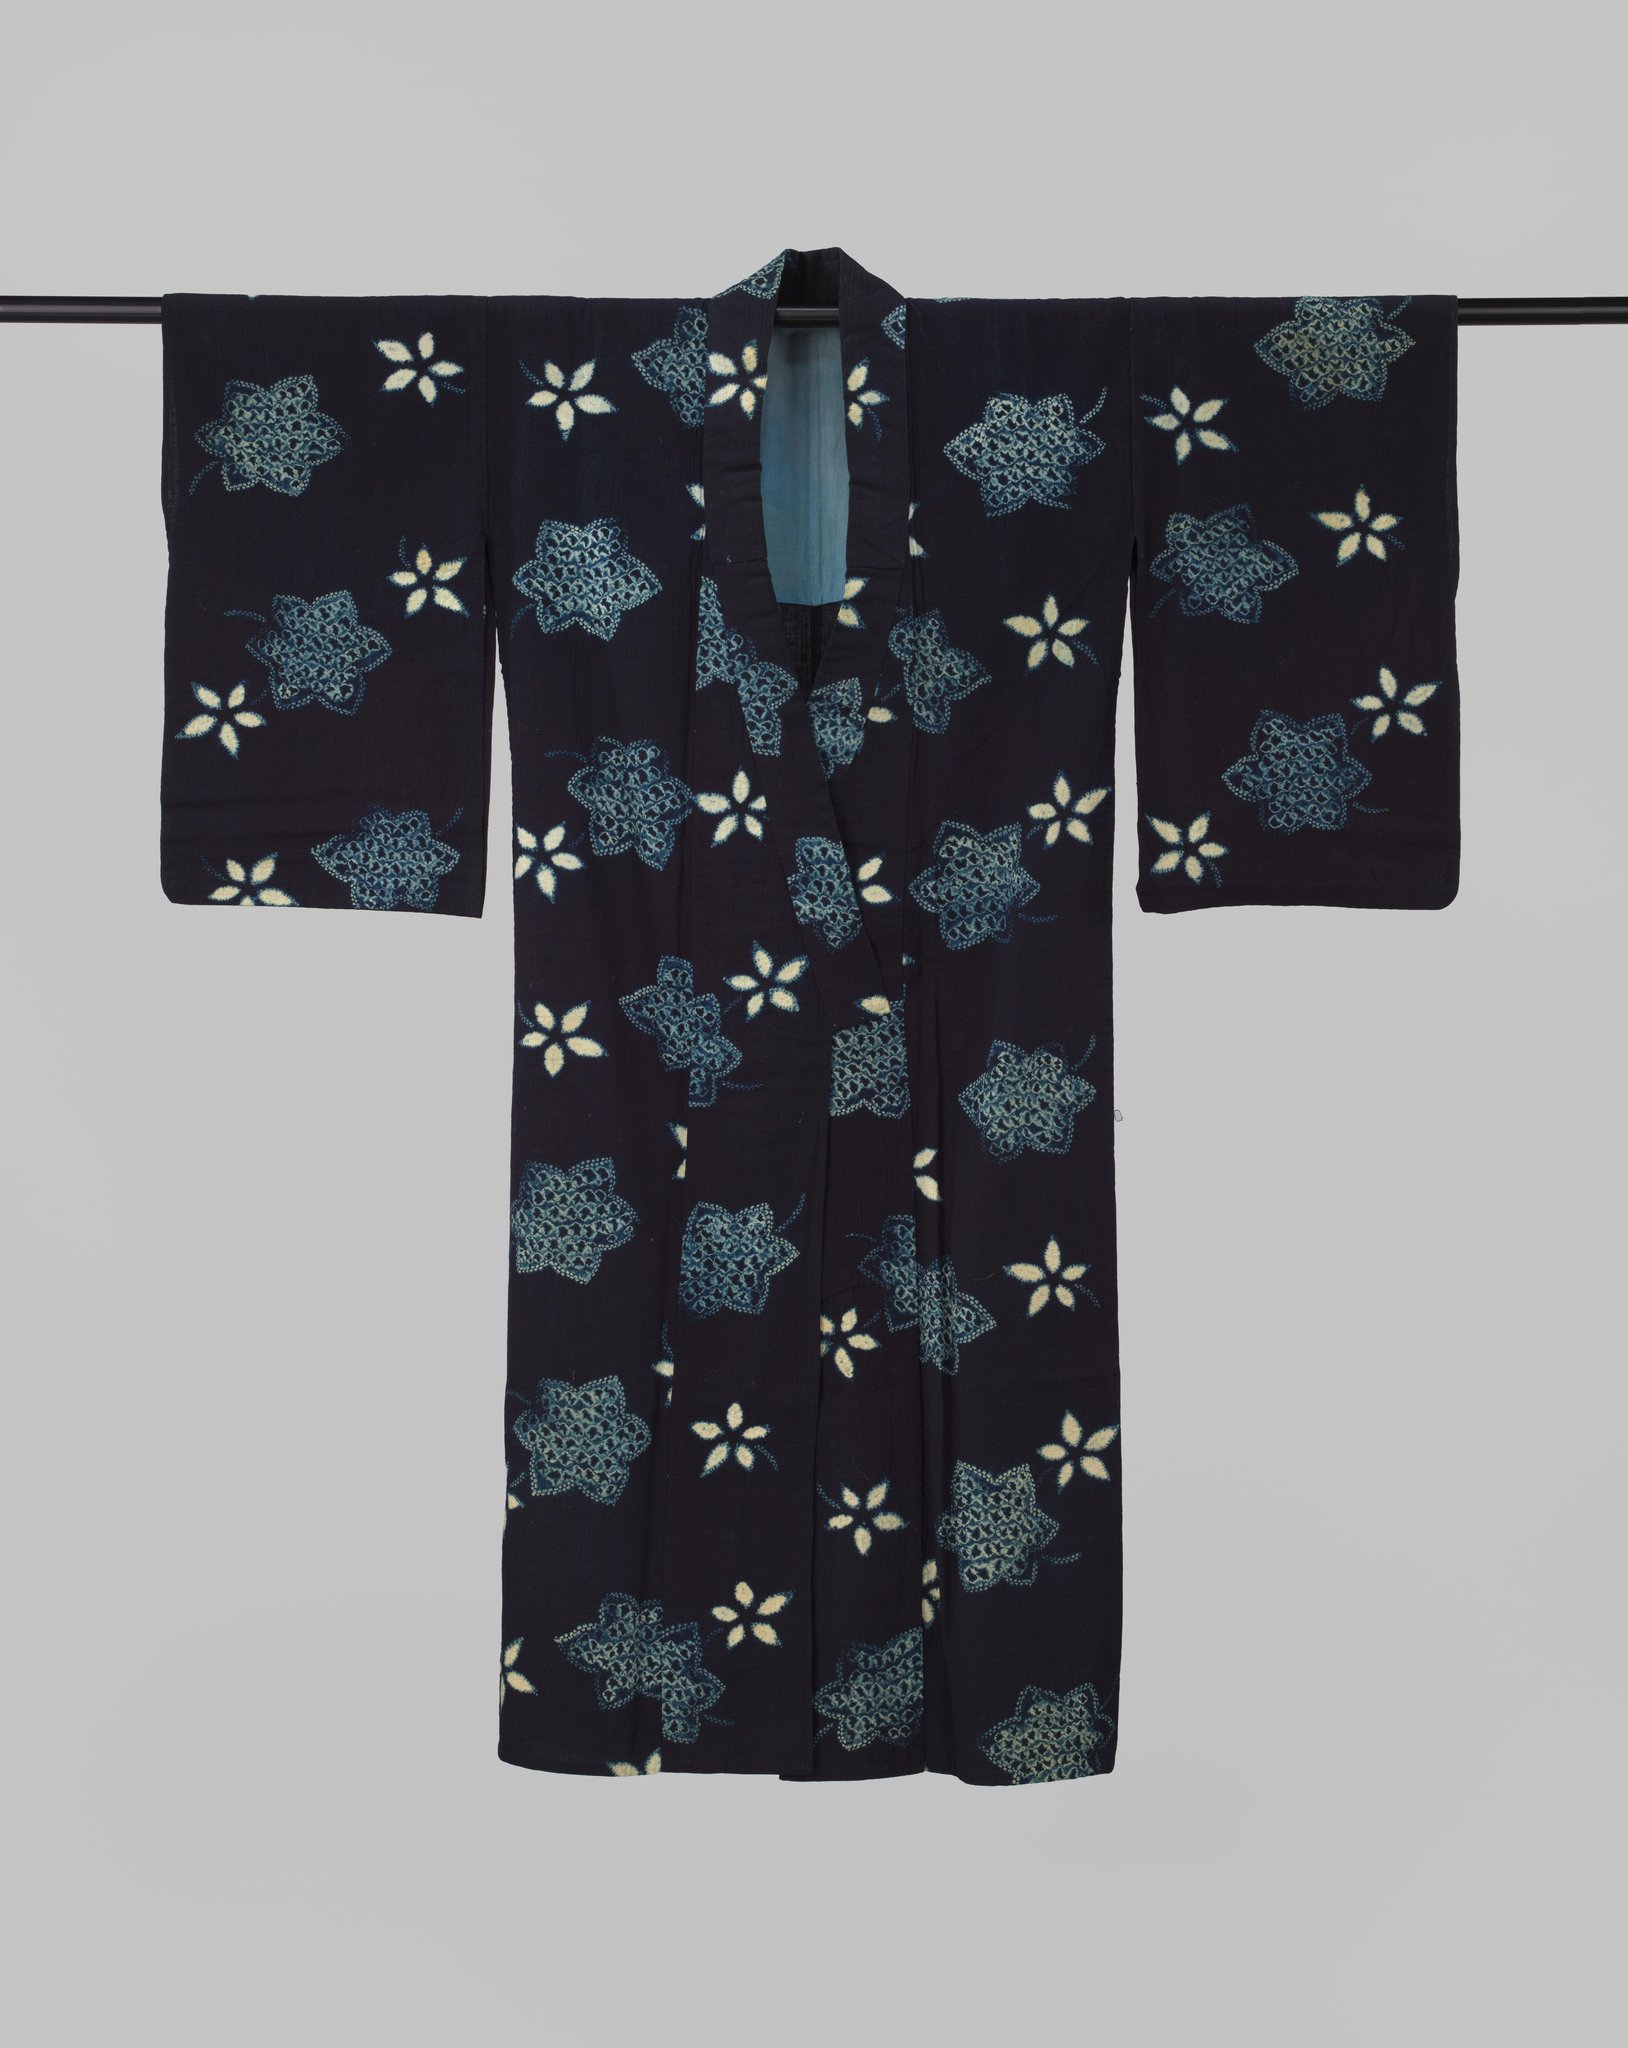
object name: kimono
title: Vrouwen kimono met esdoorn bladeren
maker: Anonymous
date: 1910-1930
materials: cotton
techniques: painting, weave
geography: japan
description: Kimono voor een vrouw met een versiering over het hele vlak van kleine en grote gestileerde esdoornbladeren. Indigo katoen met tie-dye decoratie. Voering van indigo katoen.